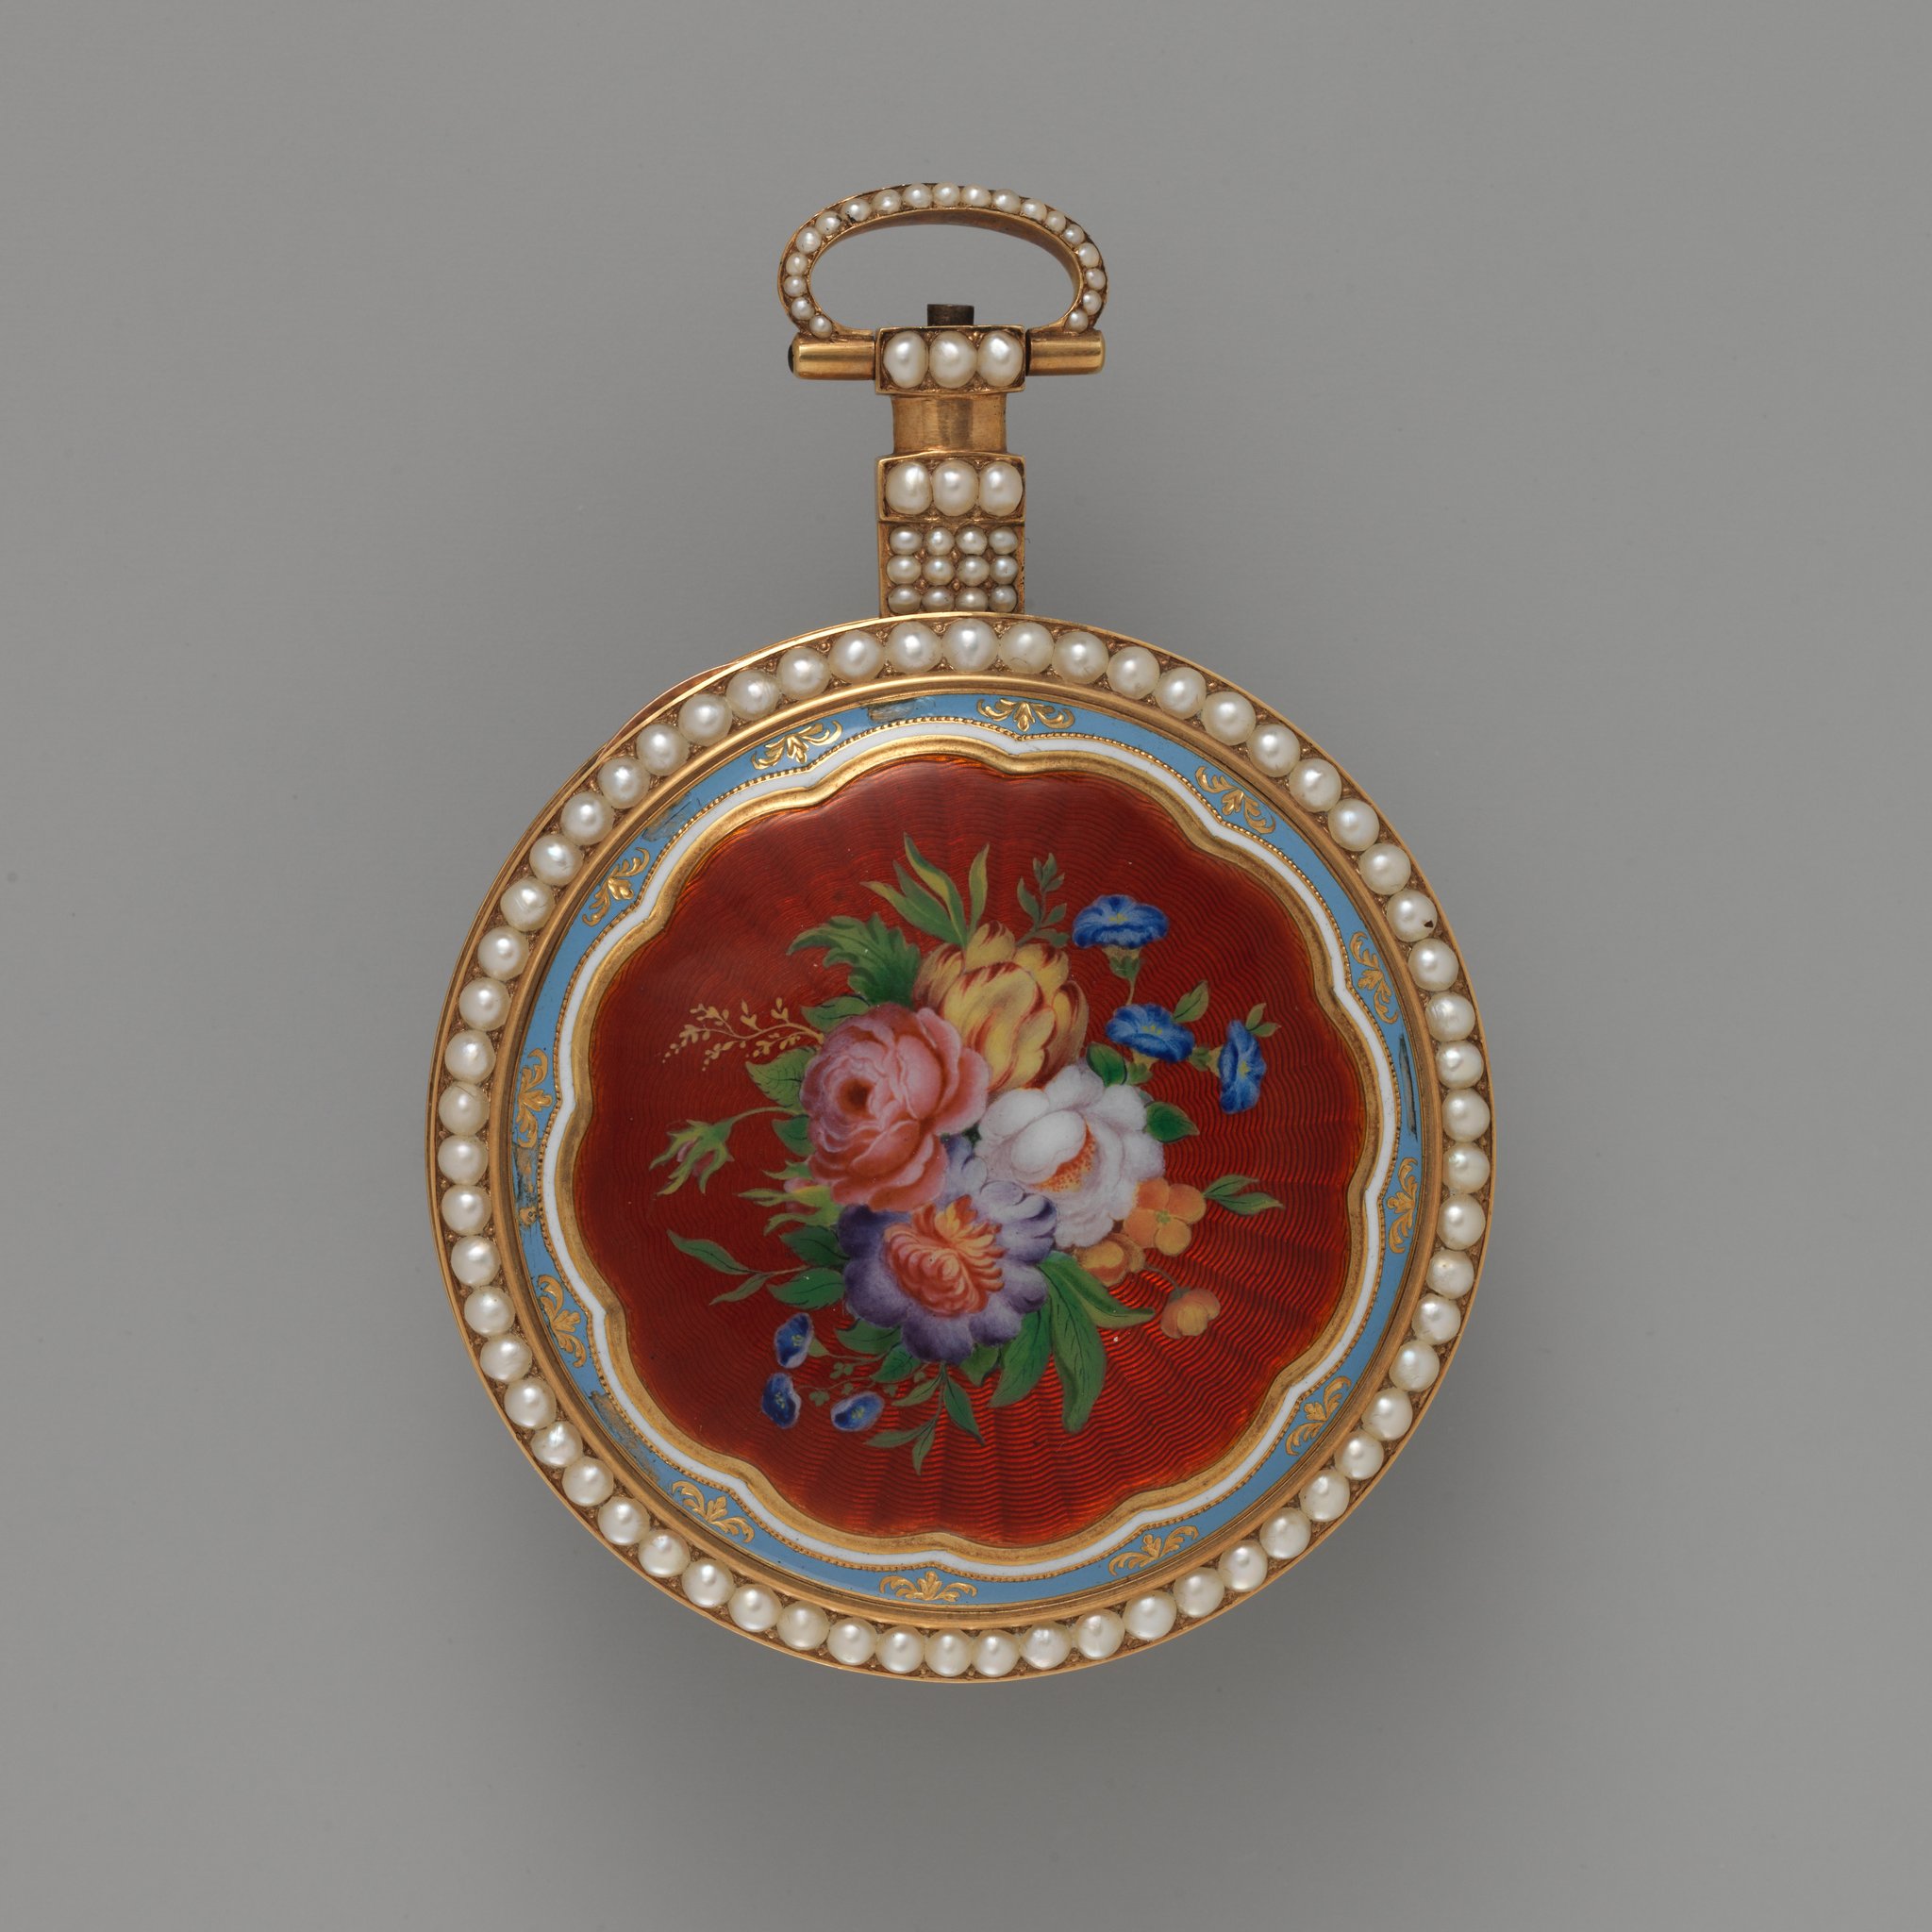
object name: watch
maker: grayhurst, harvey & co.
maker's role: maker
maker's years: 1805-1830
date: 1819-1820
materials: enamel, gold, pearl, gemstone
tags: flowers,leaves